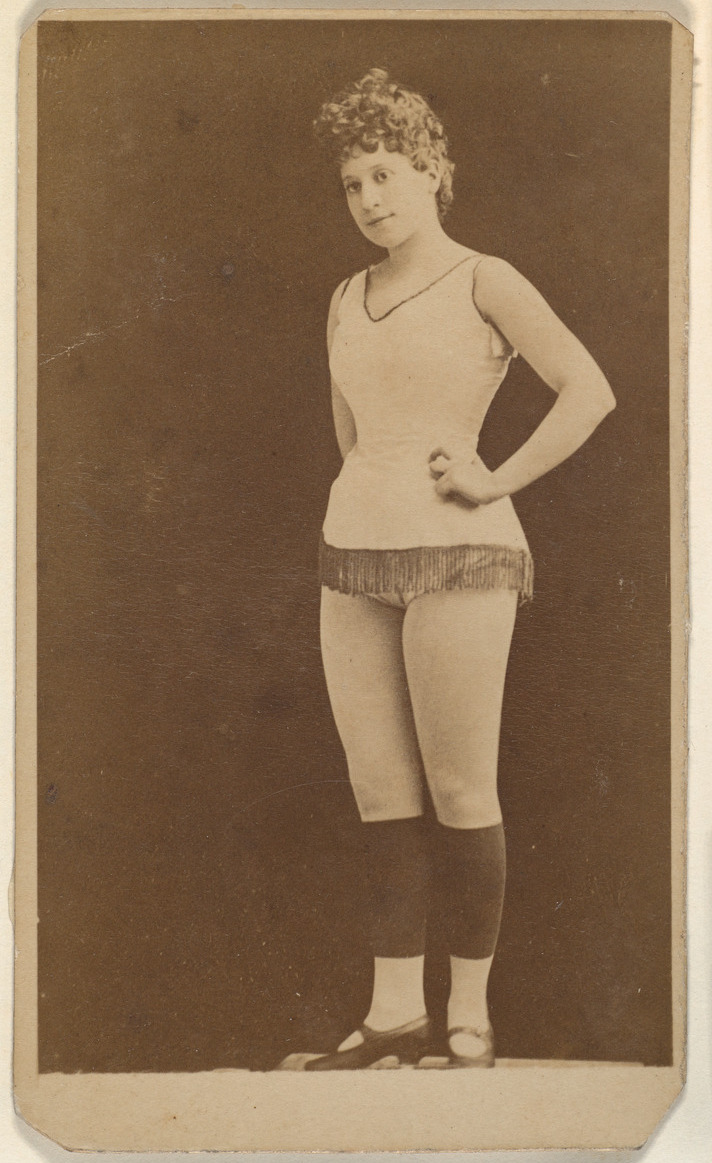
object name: photograph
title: Actress standing with hands on hips, from the Actresses series (N668)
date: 1888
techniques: albumen silver print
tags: portraits,women,actresses